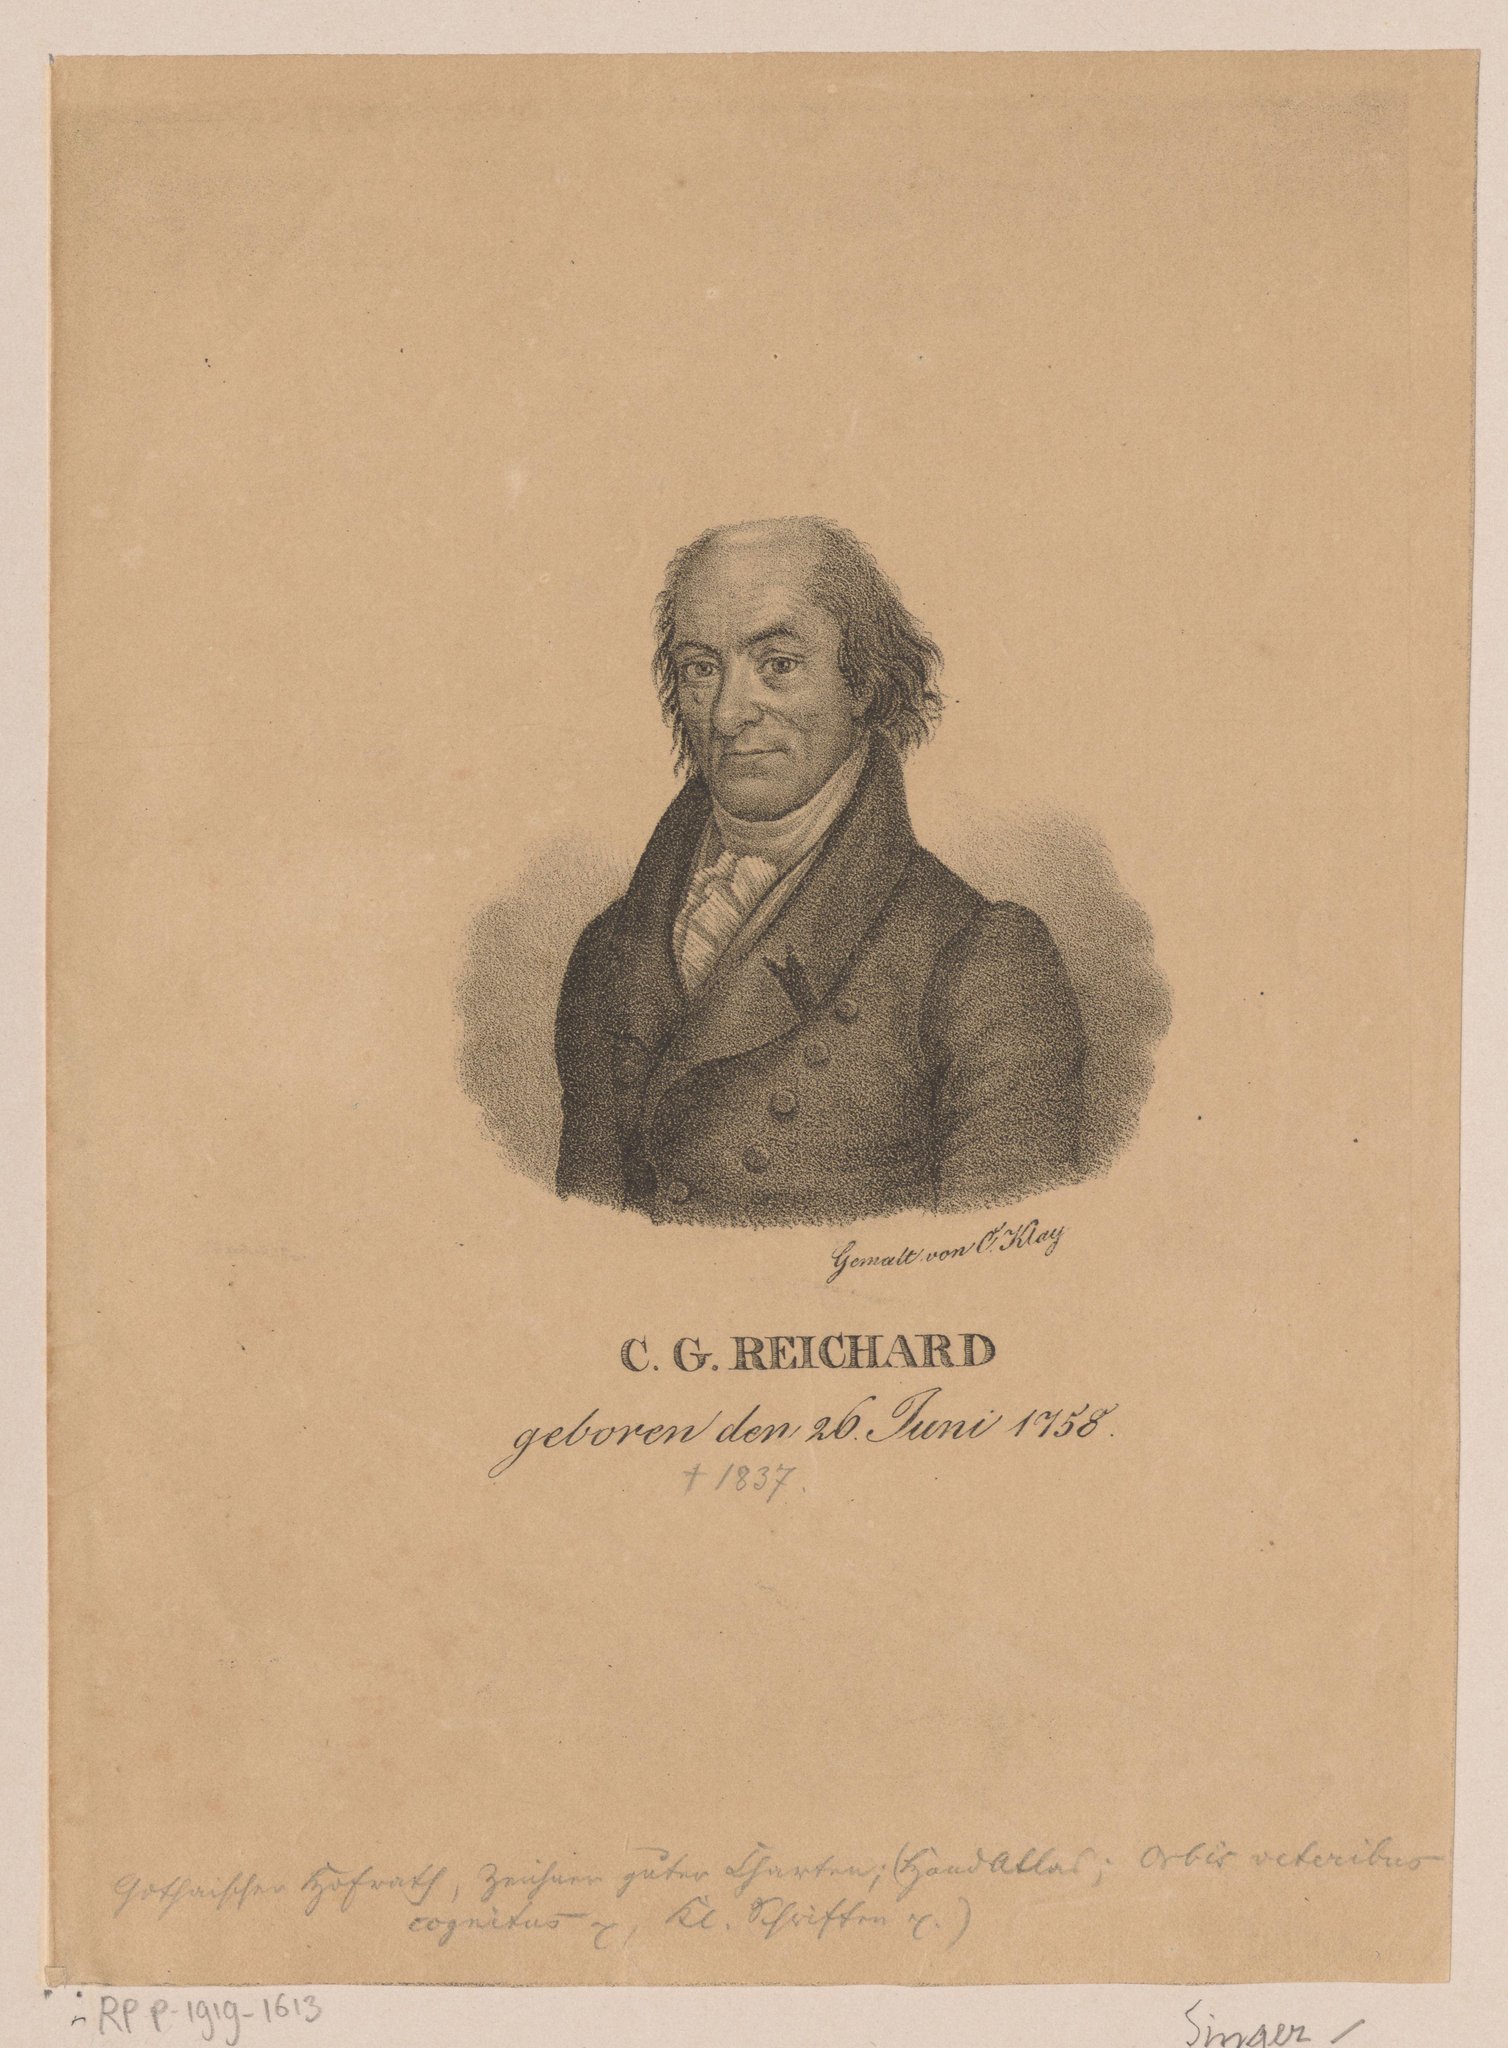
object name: print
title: Portret van Christian Gottlieb Reichard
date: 1795-1837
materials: paper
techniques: lithograph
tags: historical persons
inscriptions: collector's mark: Lugt 2228